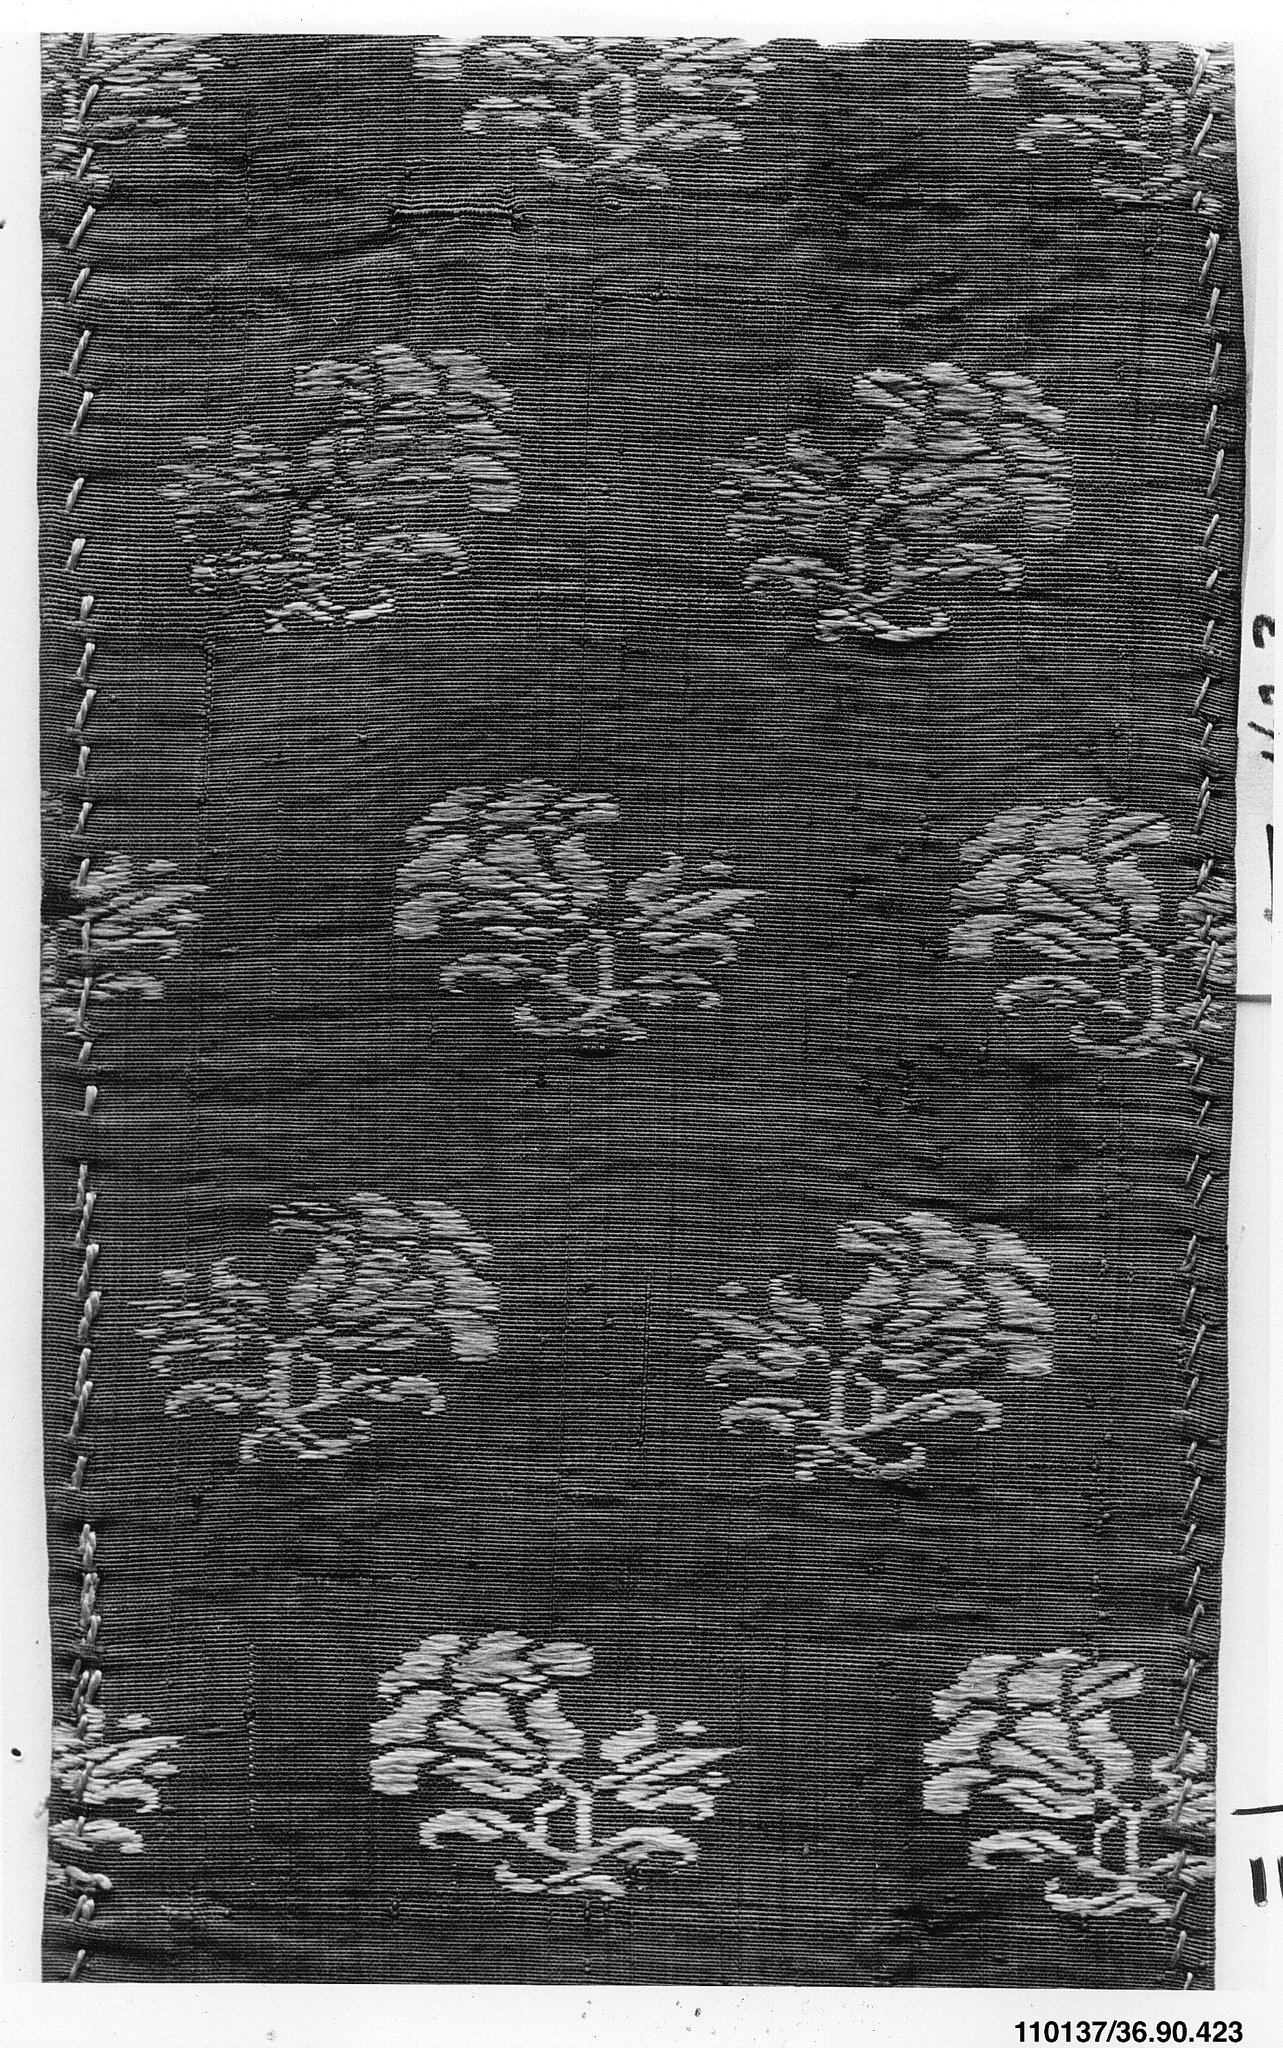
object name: piece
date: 1501-1700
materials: silk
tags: flowers